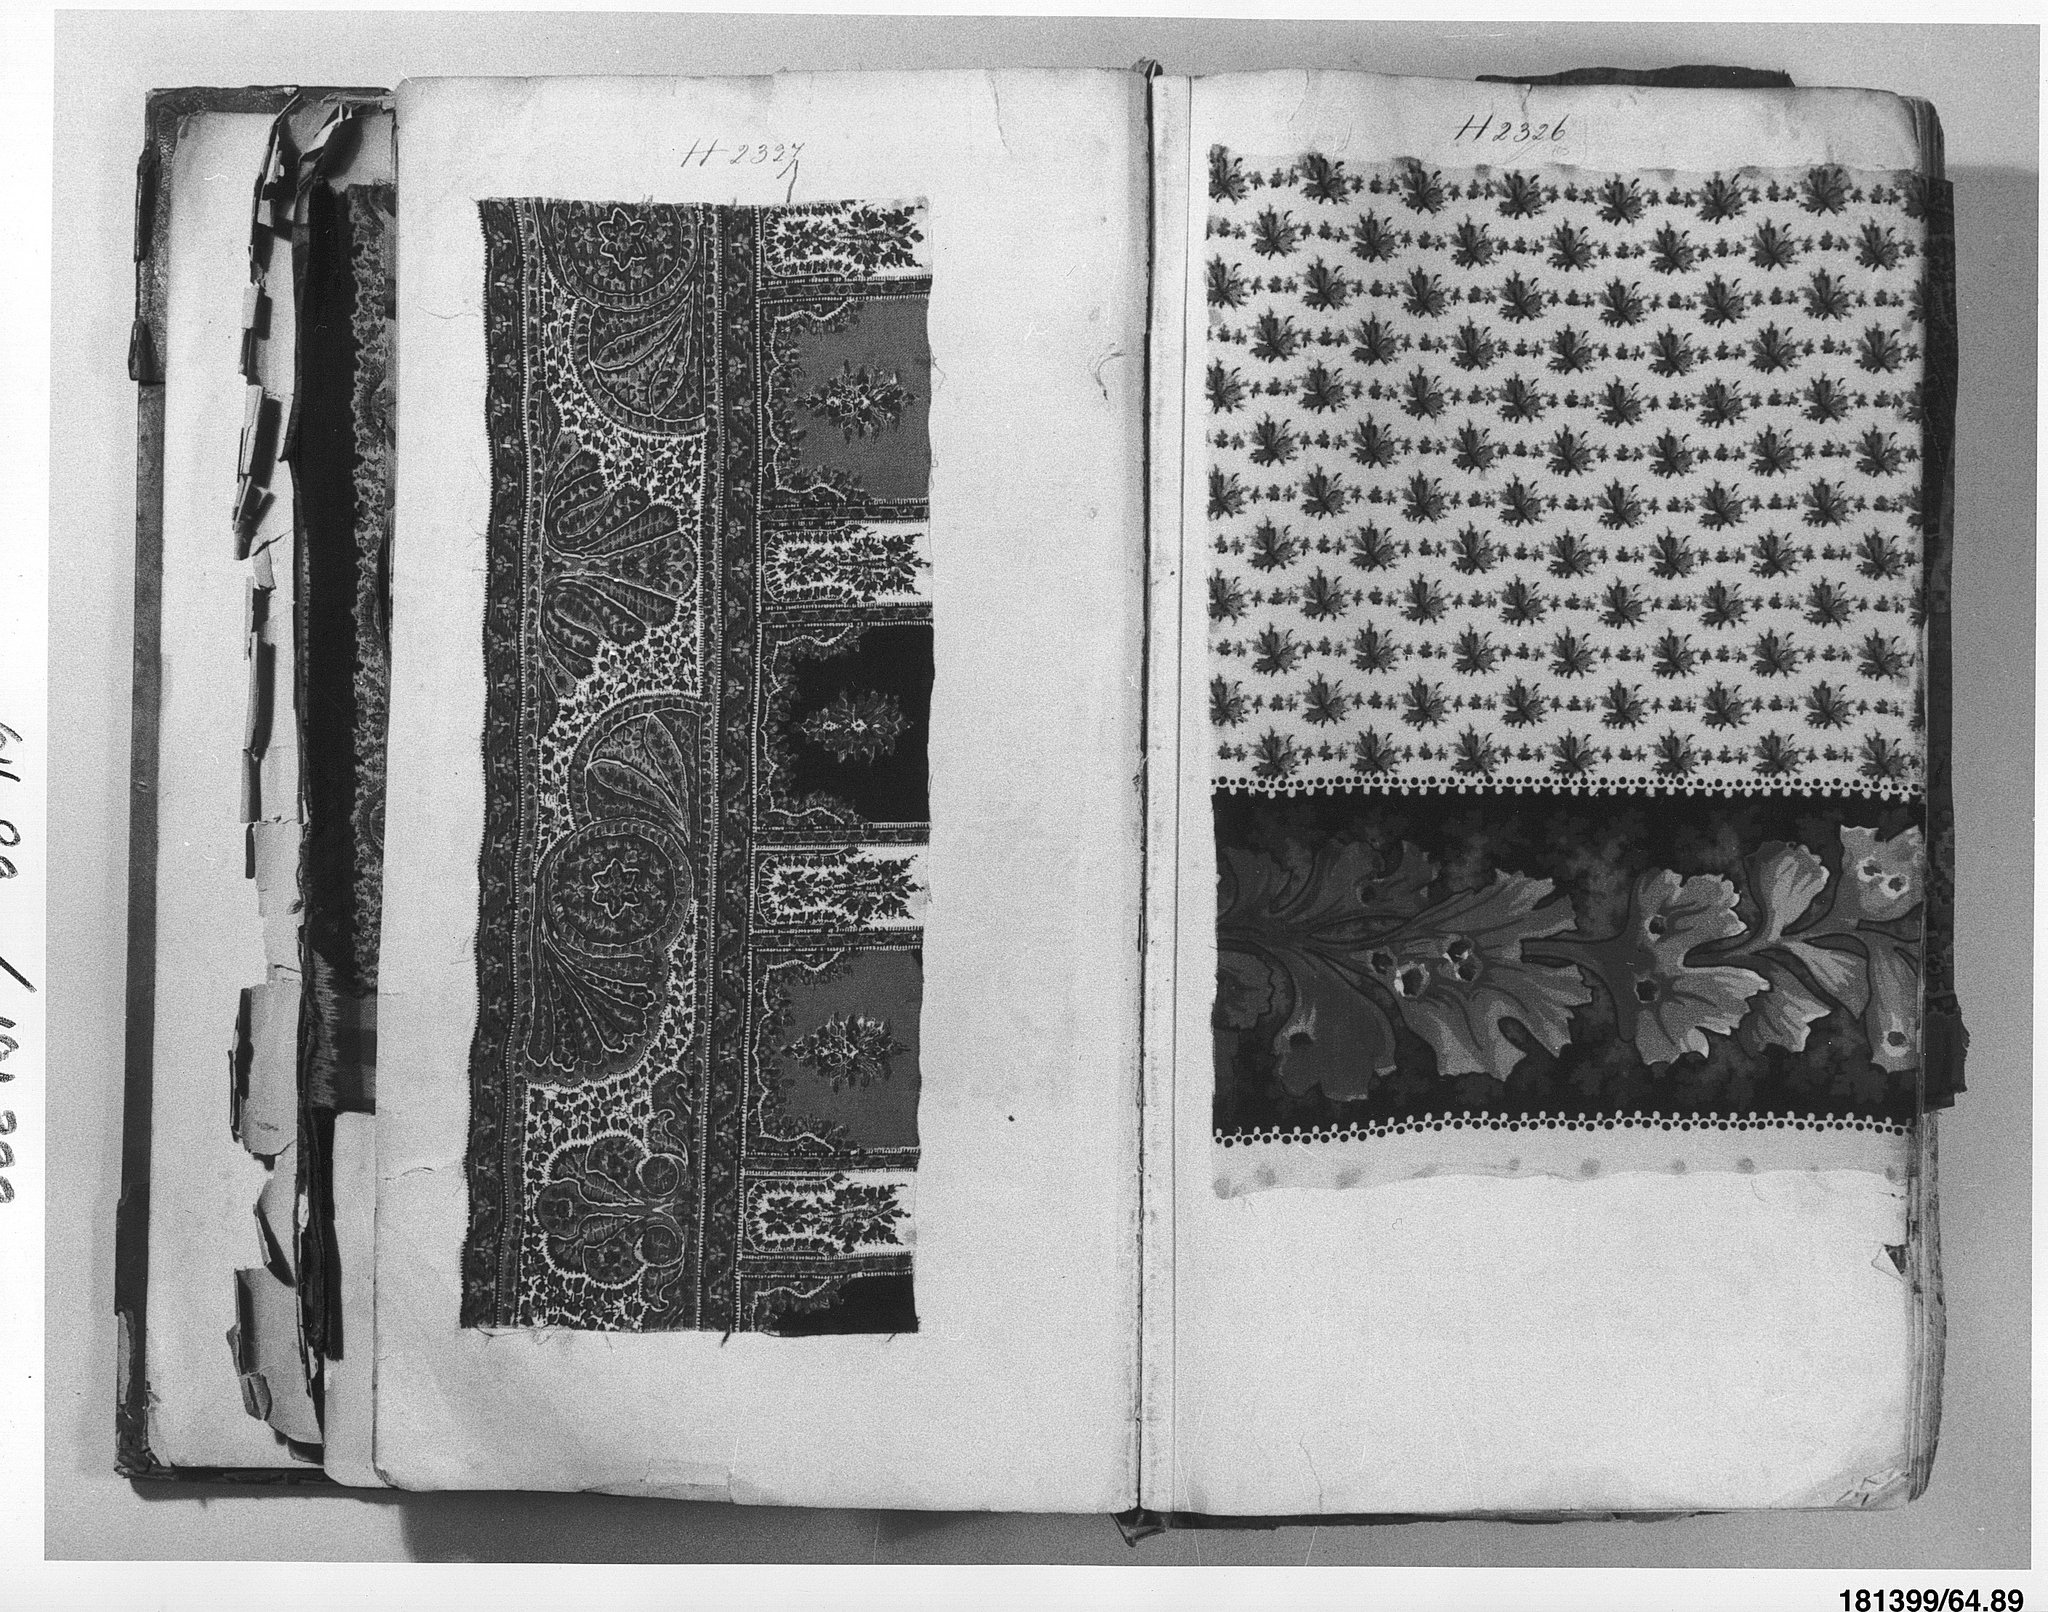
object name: sample book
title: Textile Sample Book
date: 1865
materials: cotton, leather, paper, parchment, wool